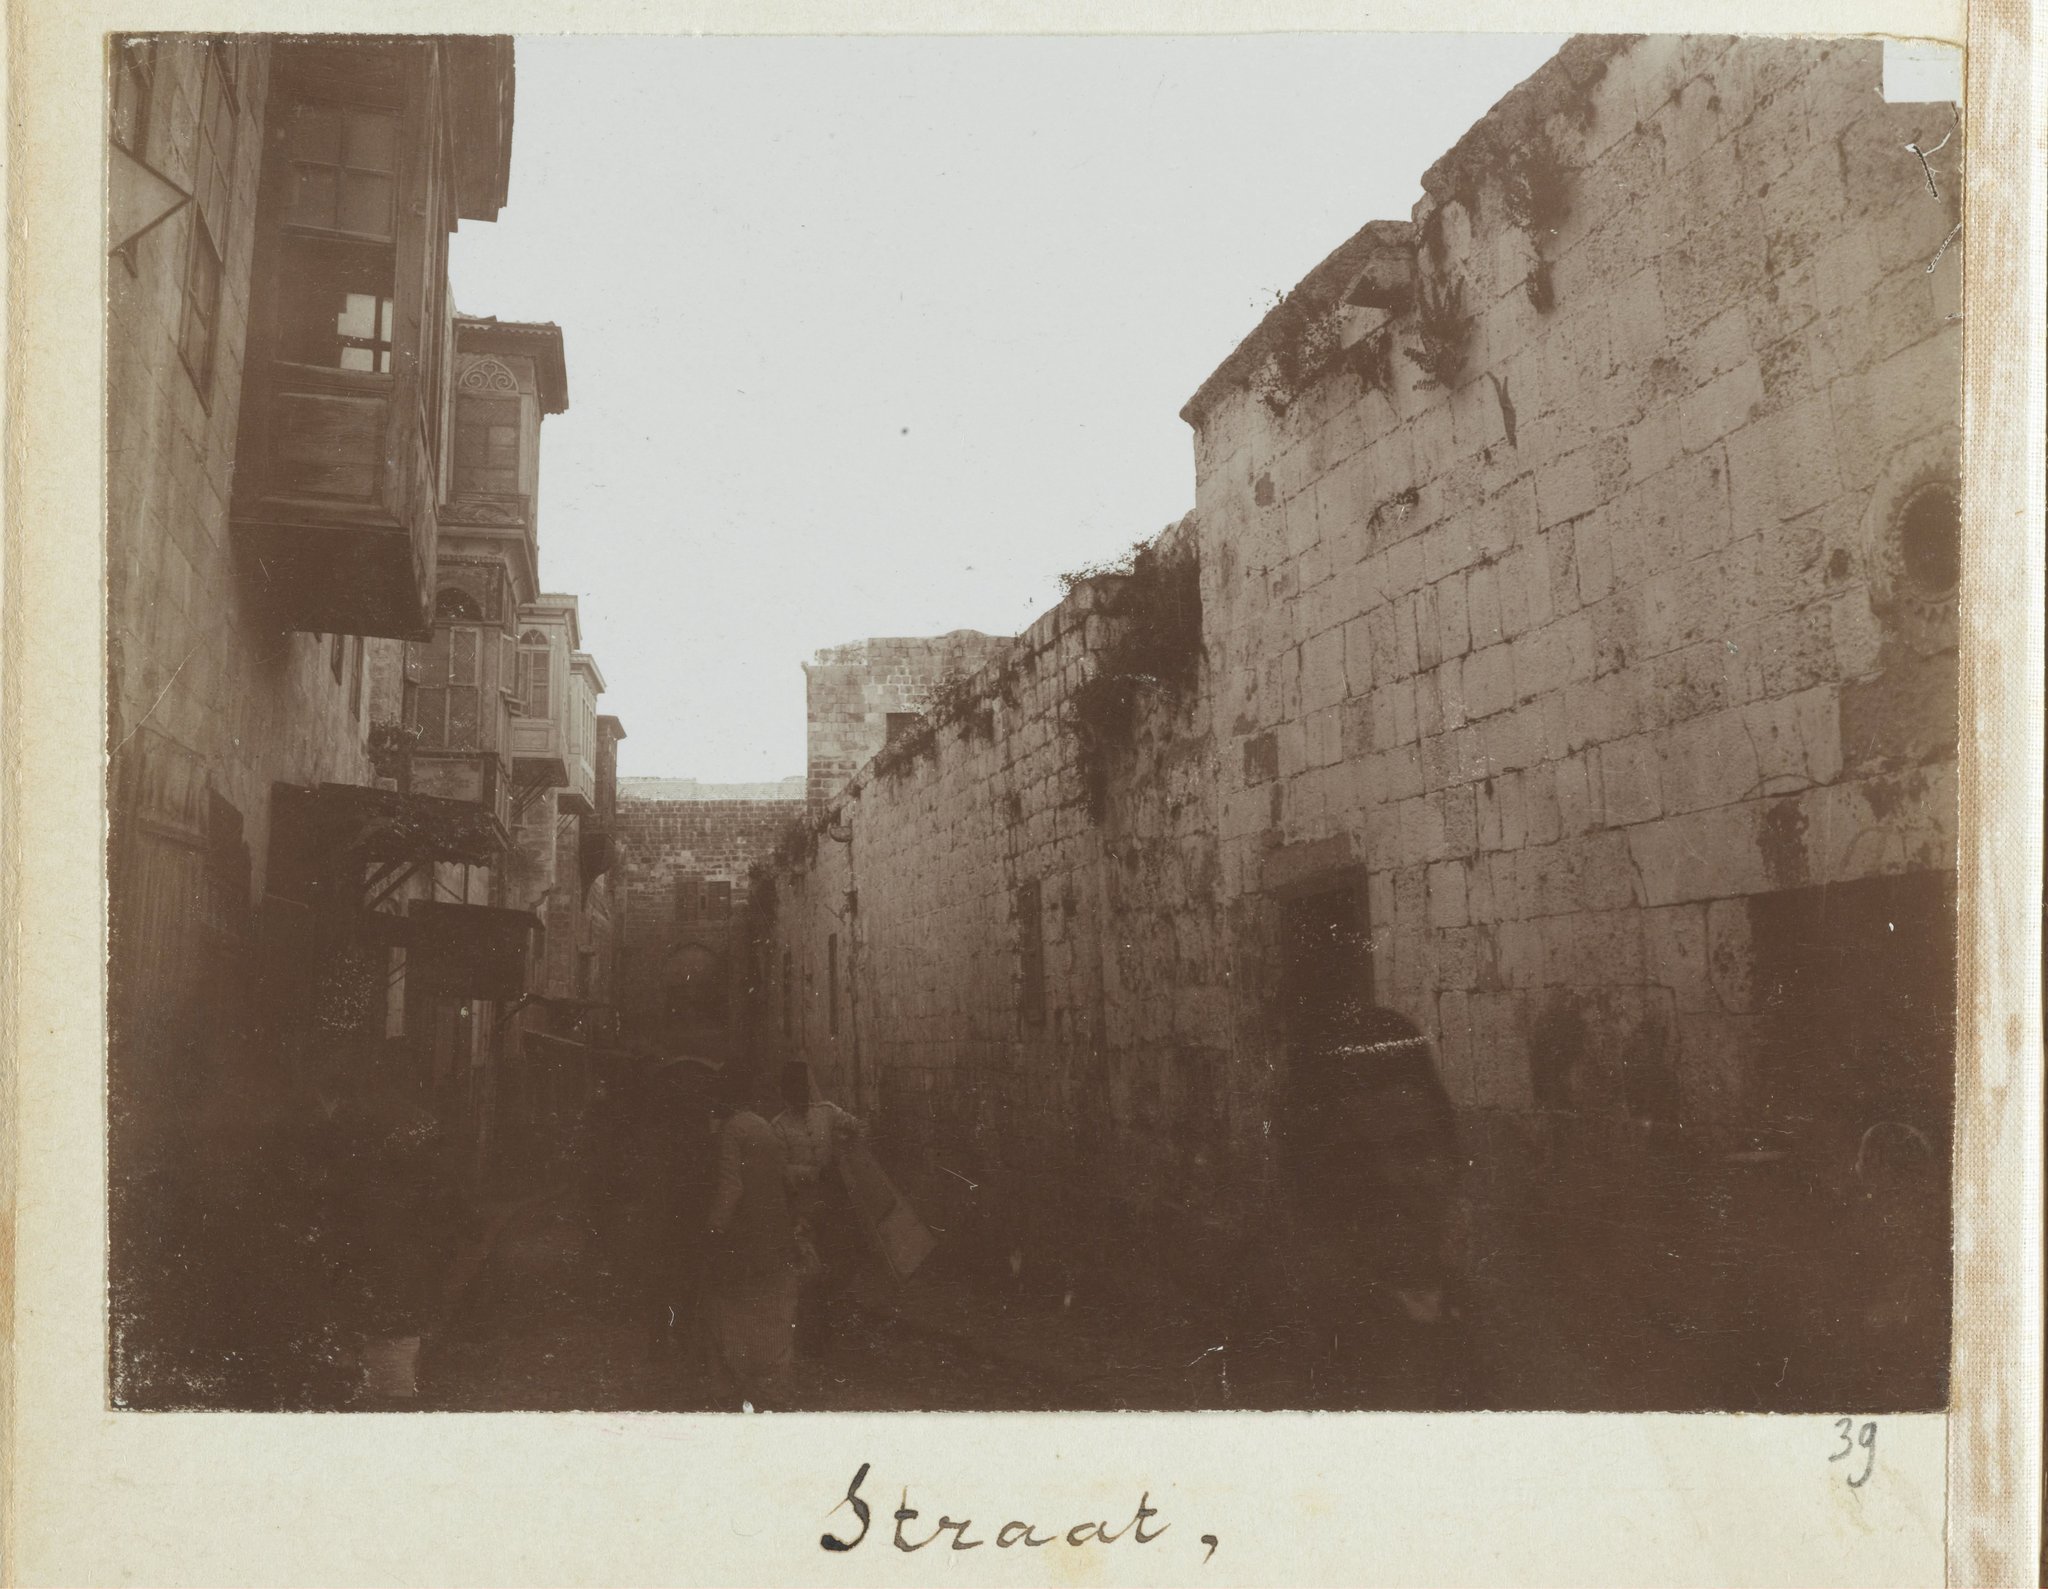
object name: page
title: Straat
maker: johannes lodewijk heldring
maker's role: fotograaf, predikant, schrijver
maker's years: 1852-1923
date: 1898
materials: paper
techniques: collodion silver print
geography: nablus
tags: street